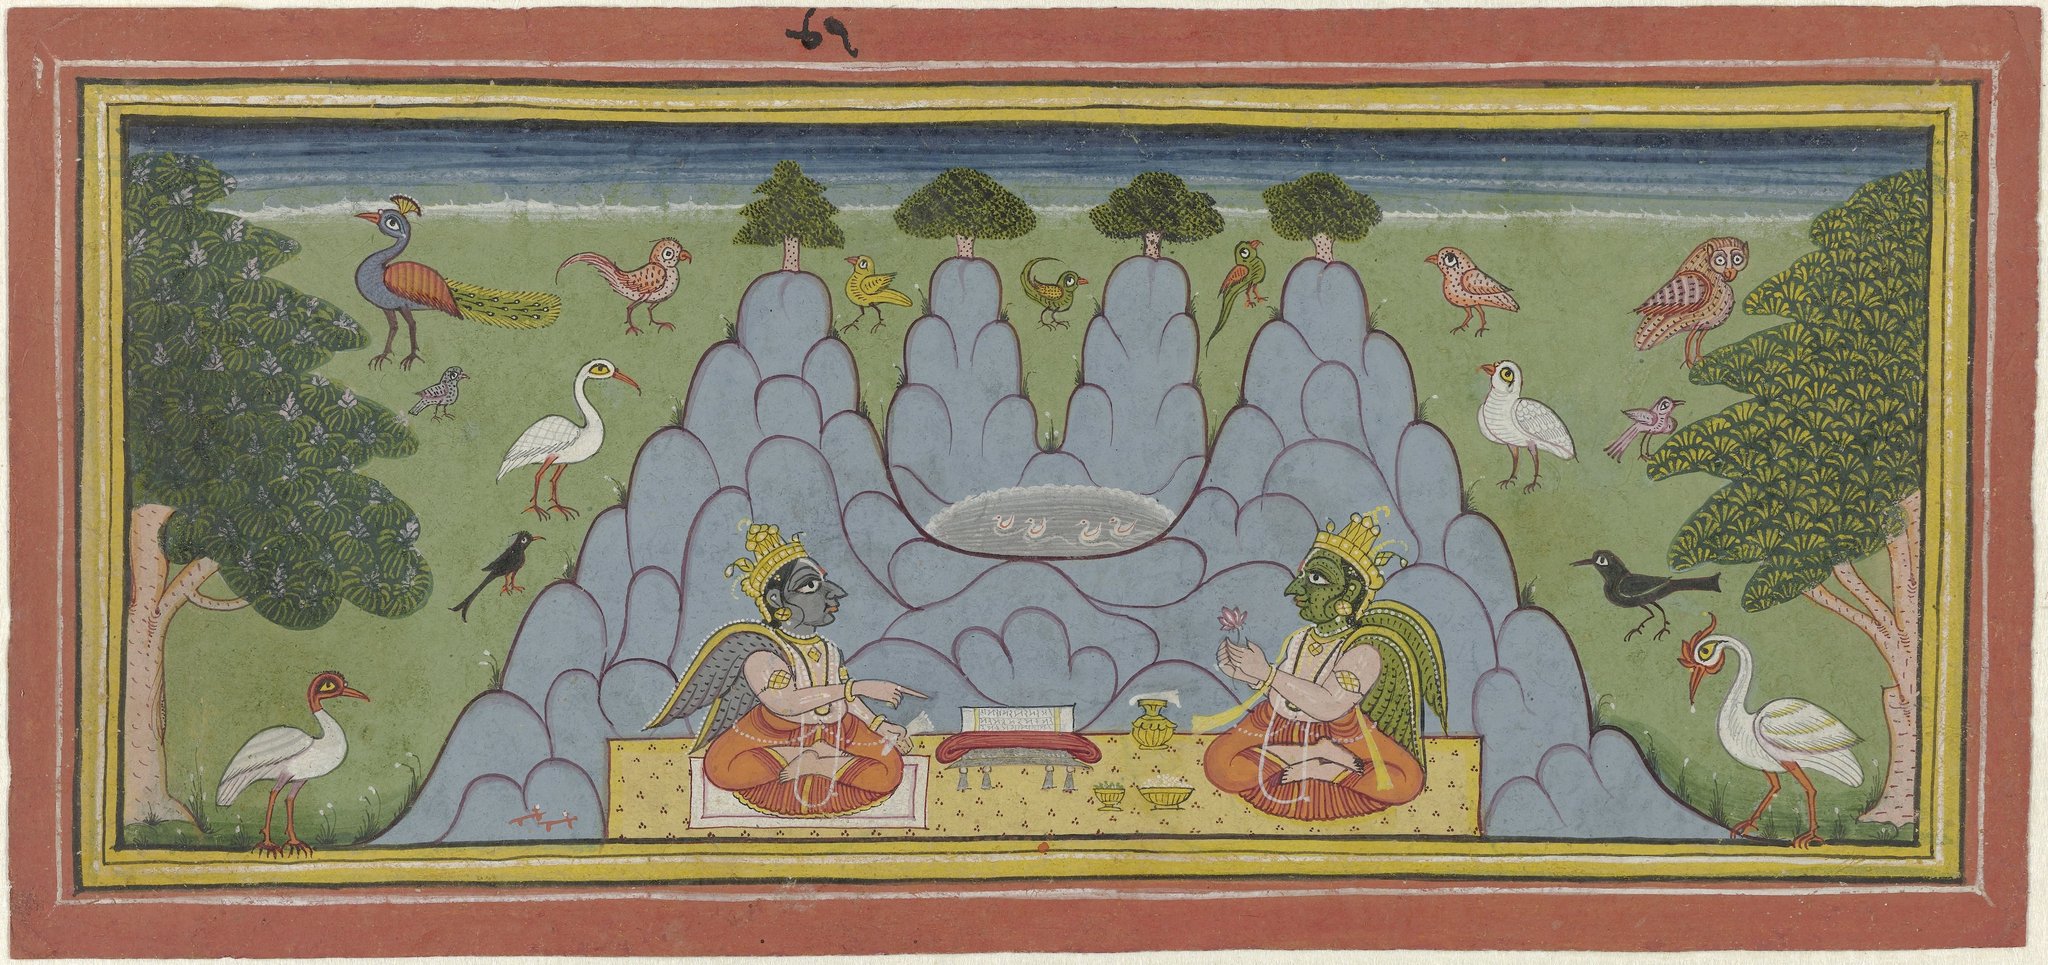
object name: indian miniature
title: Twee vogels, zittend op een berg, een heilige tekst lezend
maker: Anonymous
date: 1700-1799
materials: paint, paper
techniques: brush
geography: udaipur